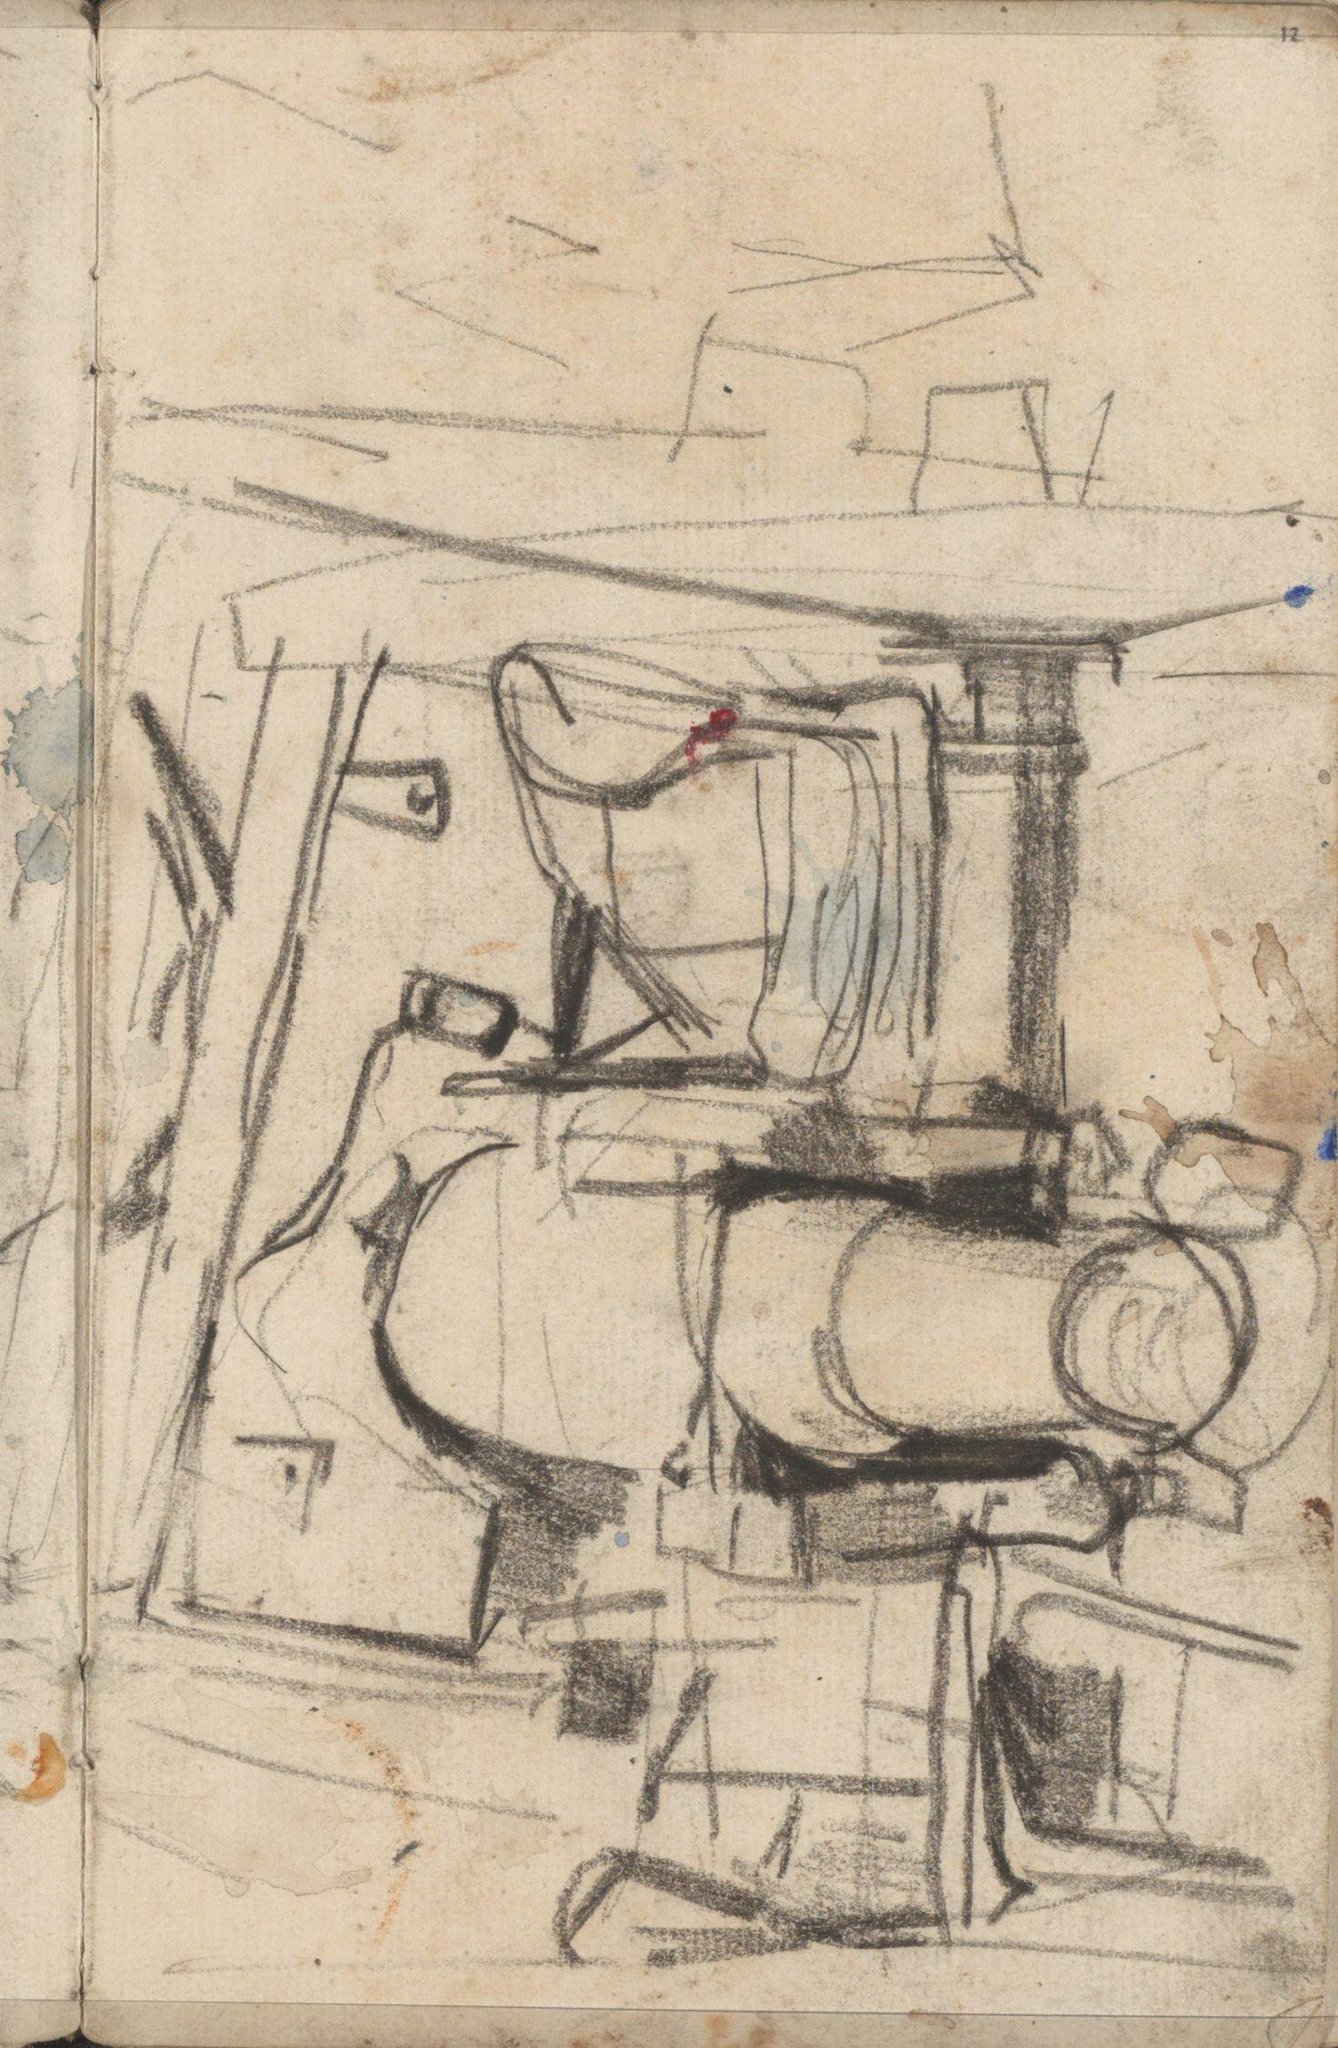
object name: sketchbook leaf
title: Kanon op affuit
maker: george hendrik breitner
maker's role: draughtsman, painter, print maker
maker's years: 1857-1923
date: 1884-1886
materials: chalk, paper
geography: the hague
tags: firearms: cannon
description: Pagina 12 uit een schetsboek met 29 bladen.